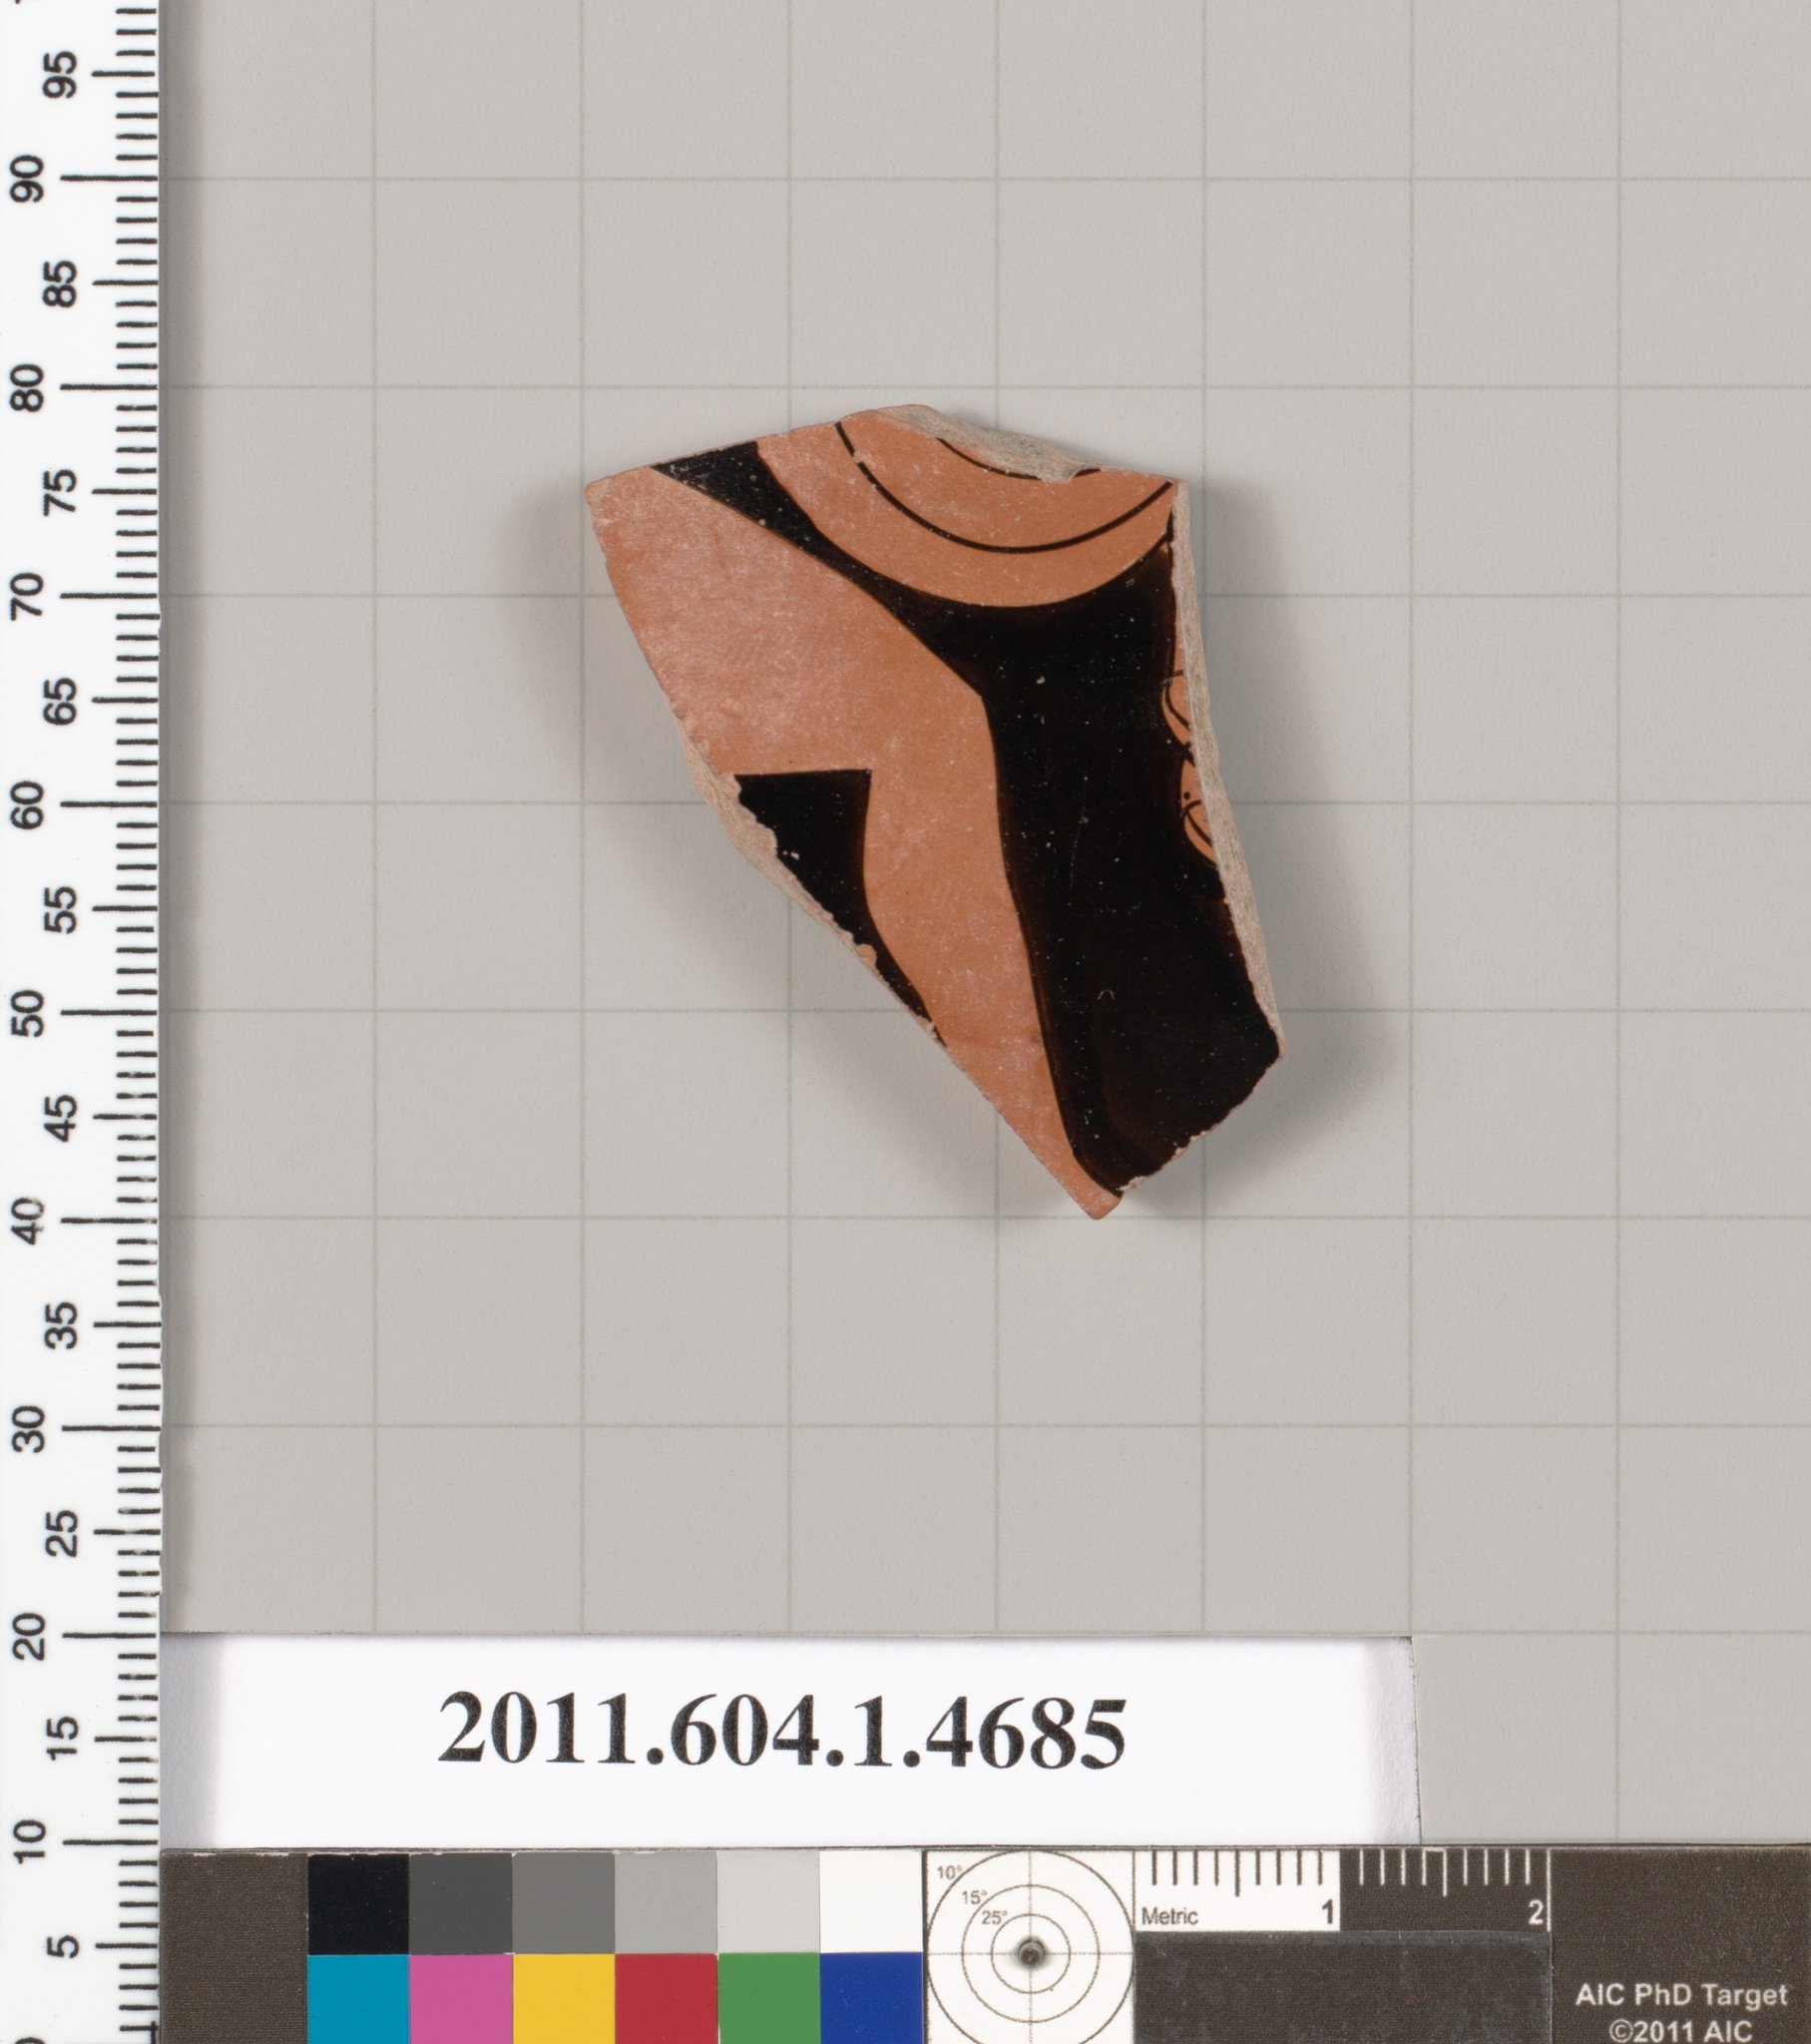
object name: kylix fragment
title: Terracotta fragment of a kylix (drinking cup)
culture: greek, attic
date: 500-480 BCE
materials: terracotta